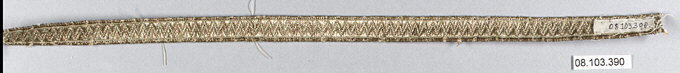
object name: galloon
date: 1601-1800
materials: metal thread